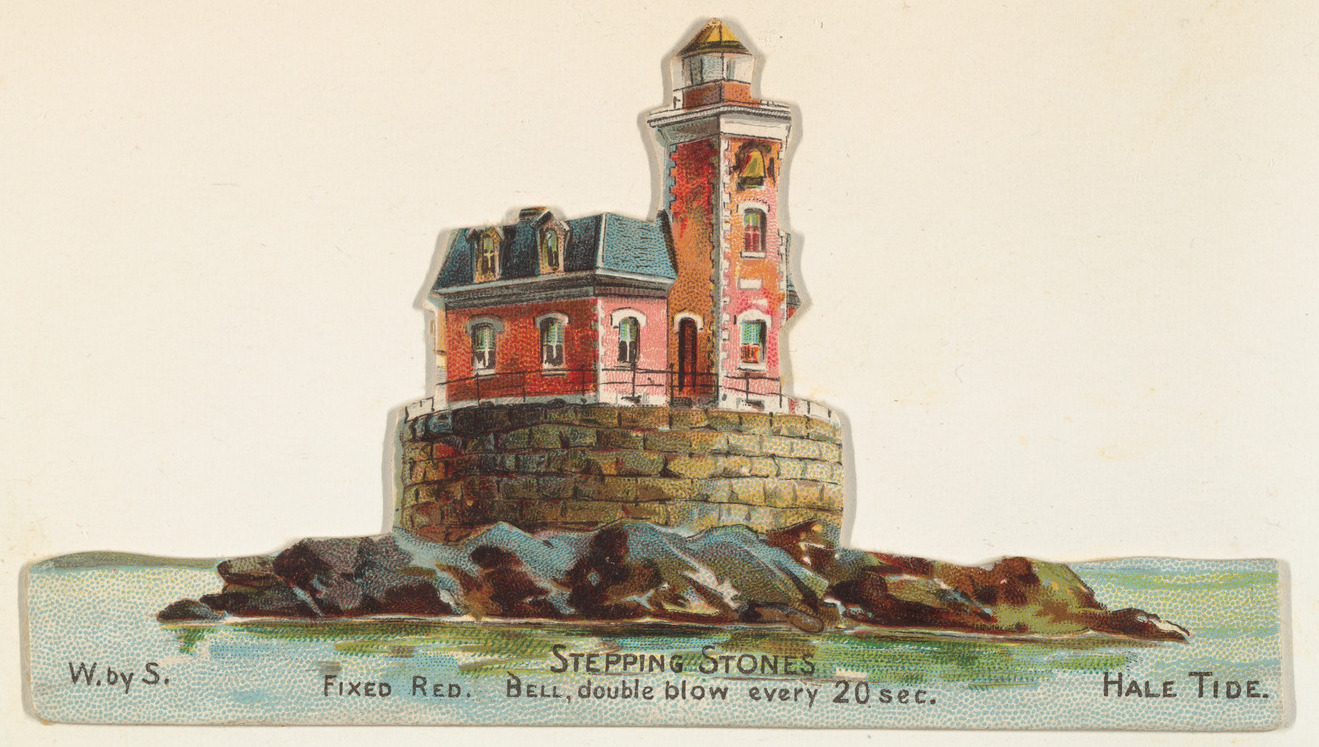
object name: print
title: Stepping Stones, from the Lighthouses series (N119) issued by Duke Sons & Co. to promote Honest Long Cut Tobacco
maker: w. duke, sons & co.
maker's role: publisher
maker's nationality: american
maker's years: 1870-1920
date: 1889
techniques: color lithograph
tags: lighthouses